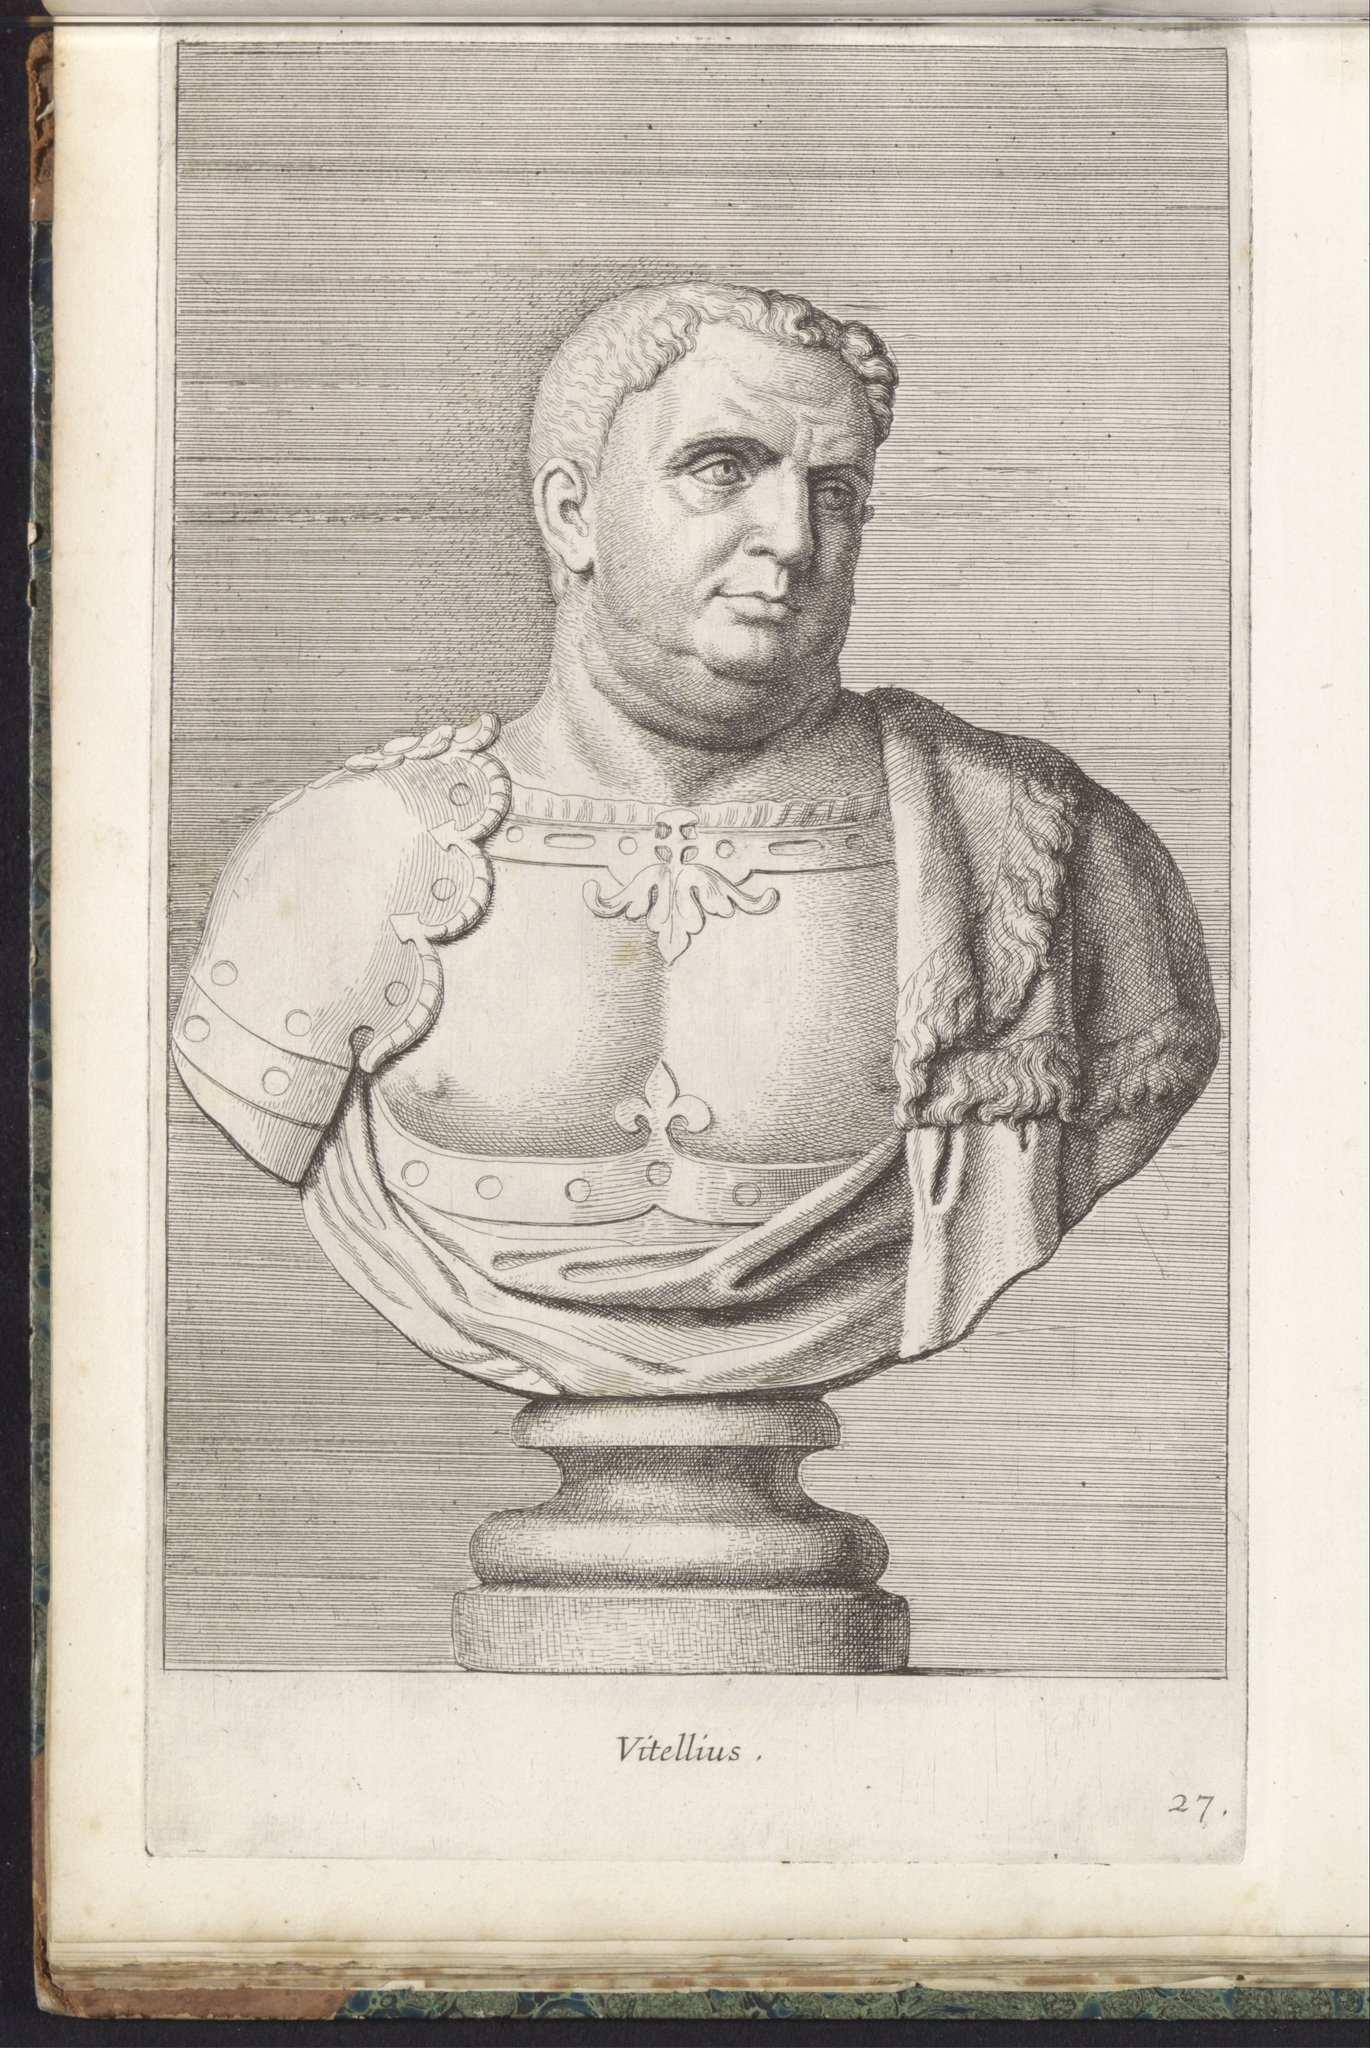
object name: album leaf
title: Buste van keizer Vitellius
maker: hubert quellinus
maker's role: print maker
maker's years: 1619-1687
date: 1646-1670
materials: paper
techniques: engraving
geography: antwerp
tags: rome, piece of sculpture, reproduction of a piece of sculpture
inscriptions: number: ‘53’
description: Klassieke buste van een man met onderkin, een harnas dragend. Over zijn schouder ligt een mantel. De prent maakt deel uit van een album met een serie prenten naar de sculpturen in de verzameling van Gerard Reynst.